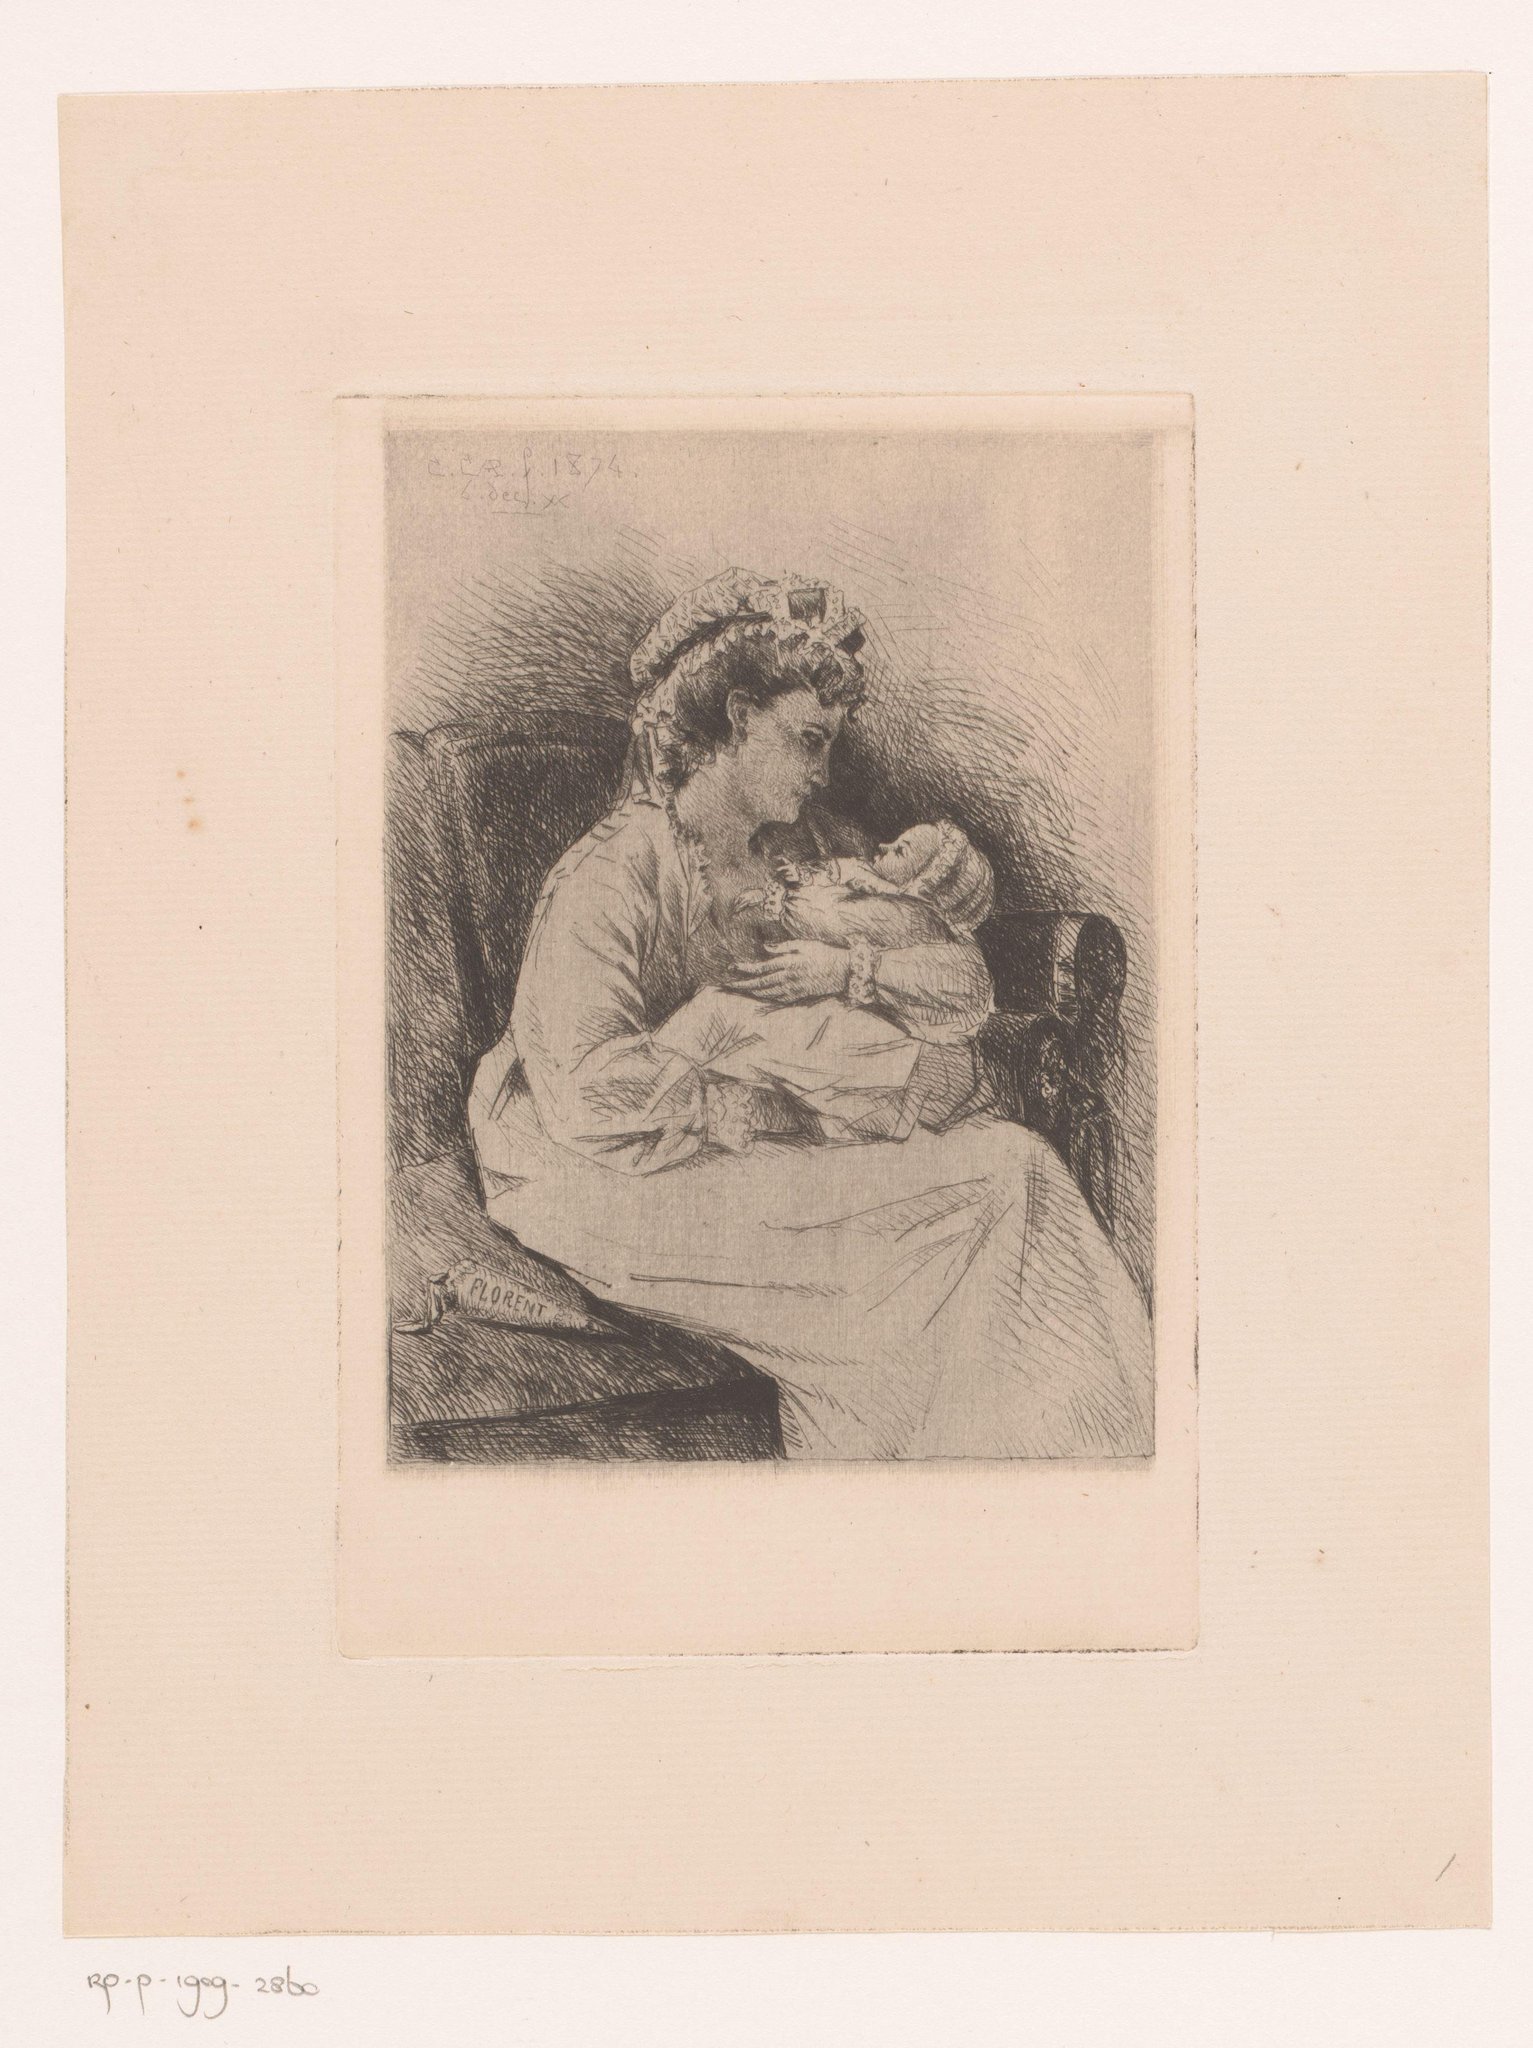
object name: print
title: Moeder met baby in de armen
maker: constant aimé marie cap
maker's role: print maker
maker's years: 1842-1915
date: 1874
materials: paper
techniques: drypoint, etching, intaglio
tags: mother and baby or young child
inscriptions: collector's mark: Lugt 2228